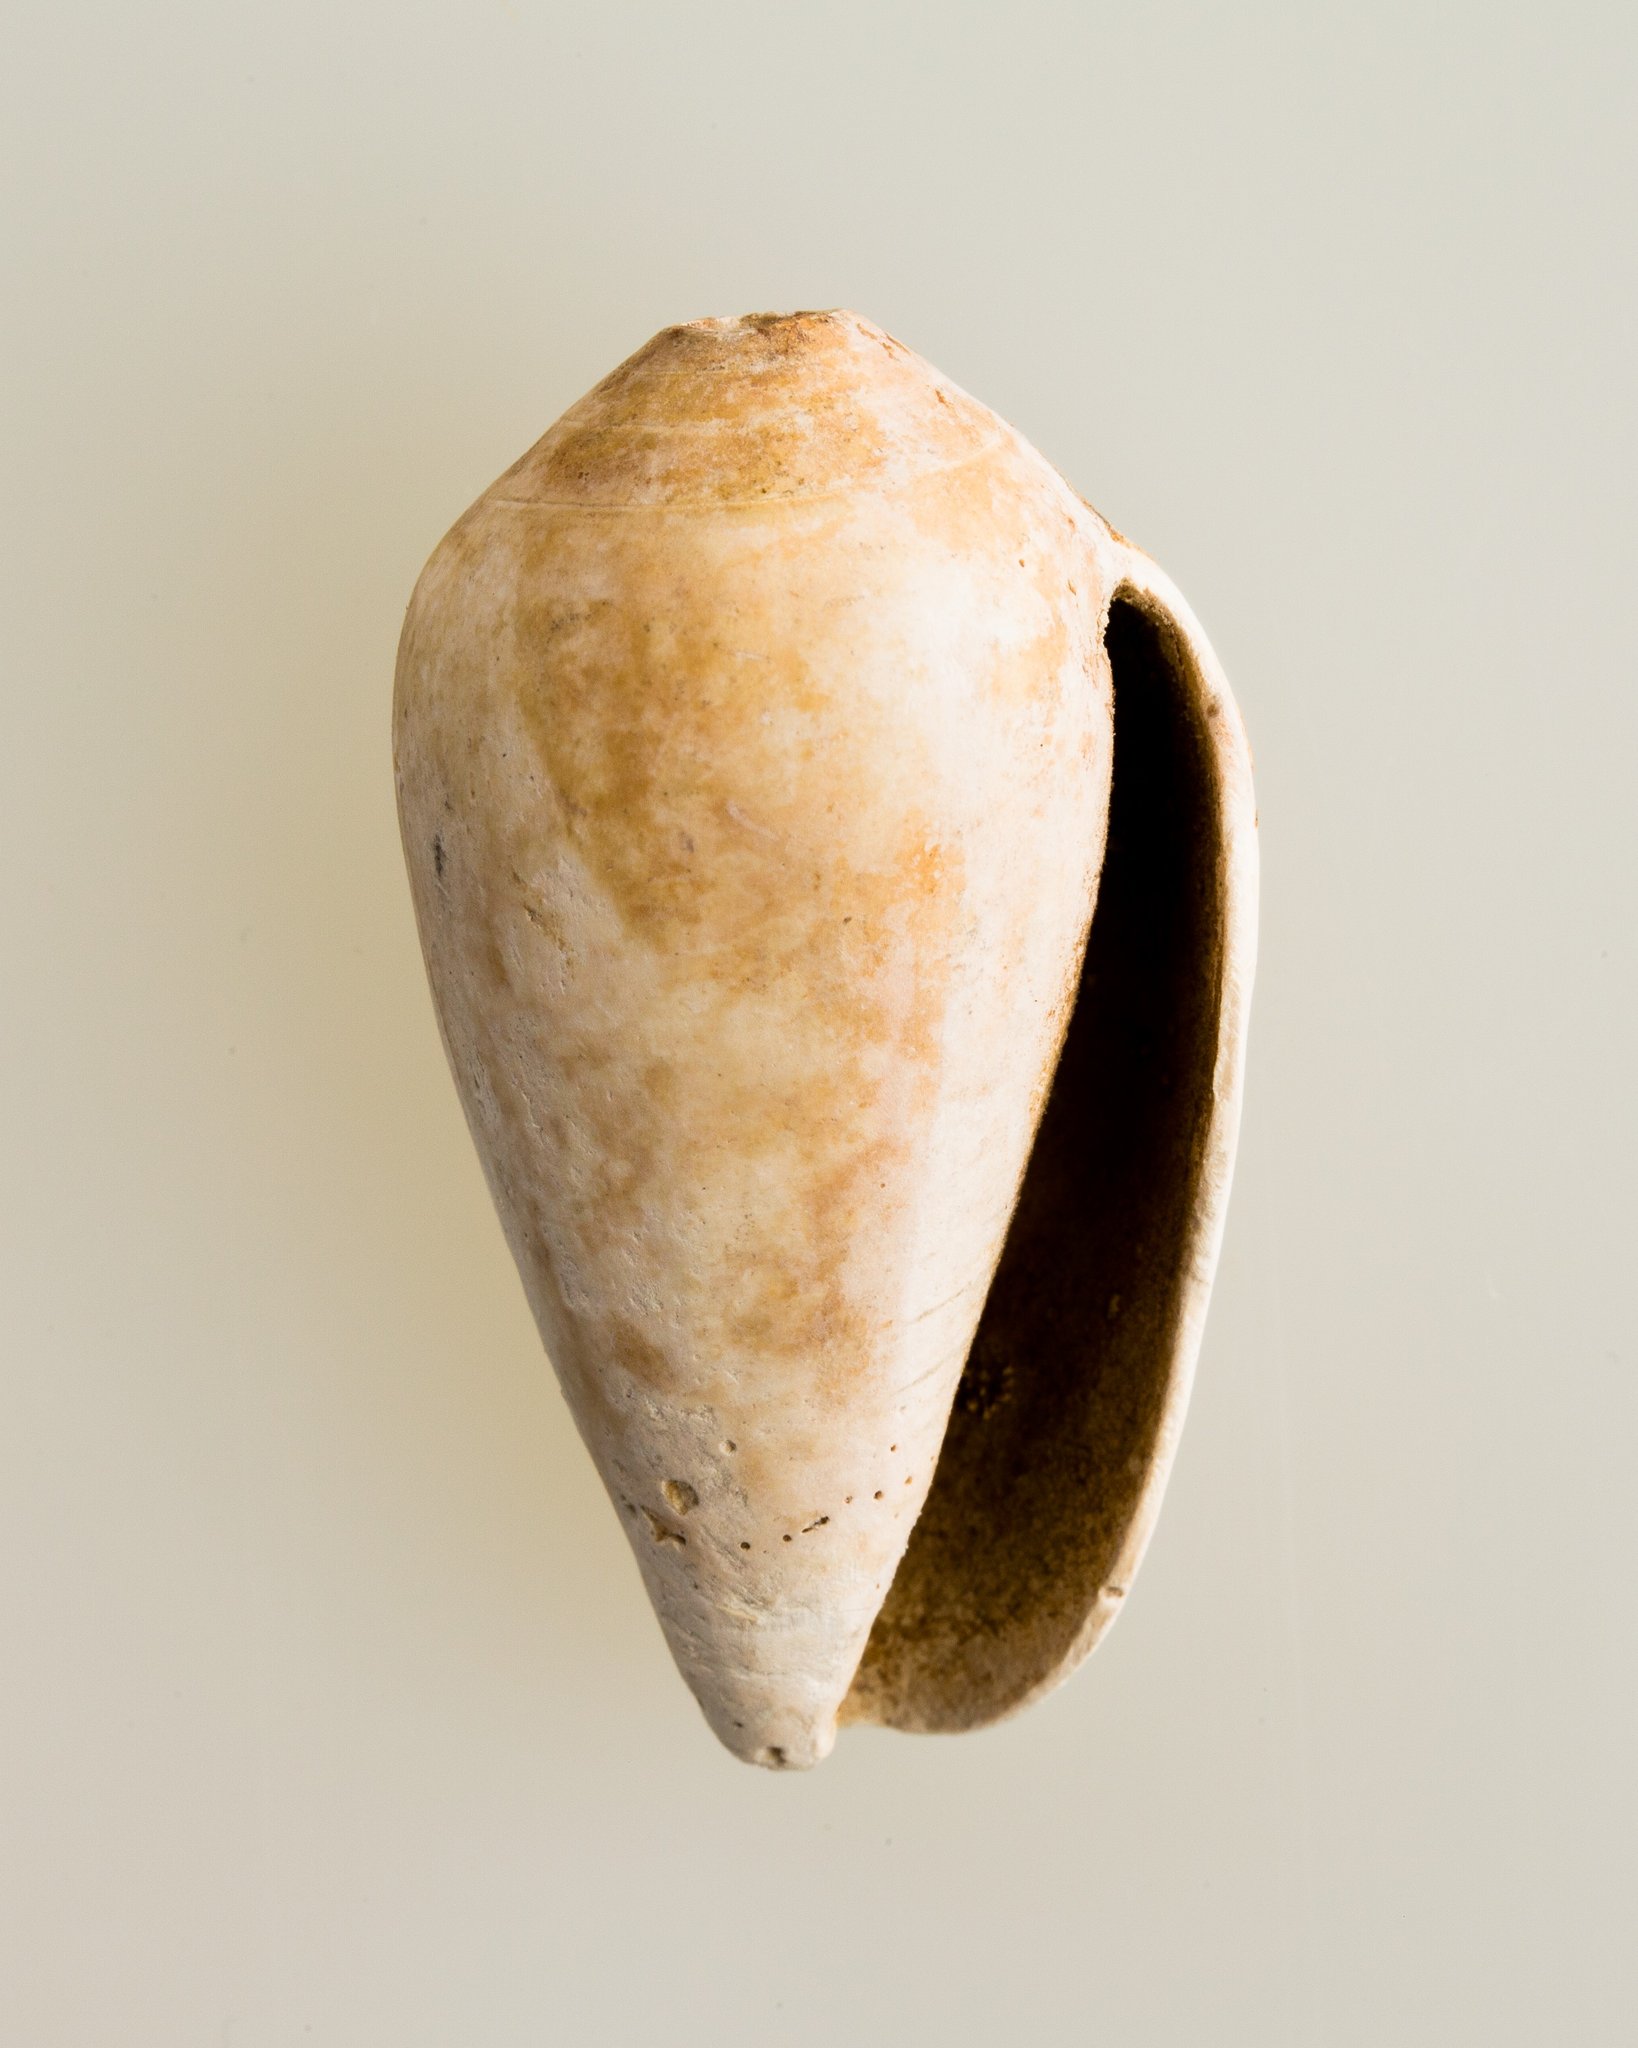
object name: pendant, shell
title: Shell pendant or bead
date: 3850-2960 BCE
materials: shell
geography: egypt